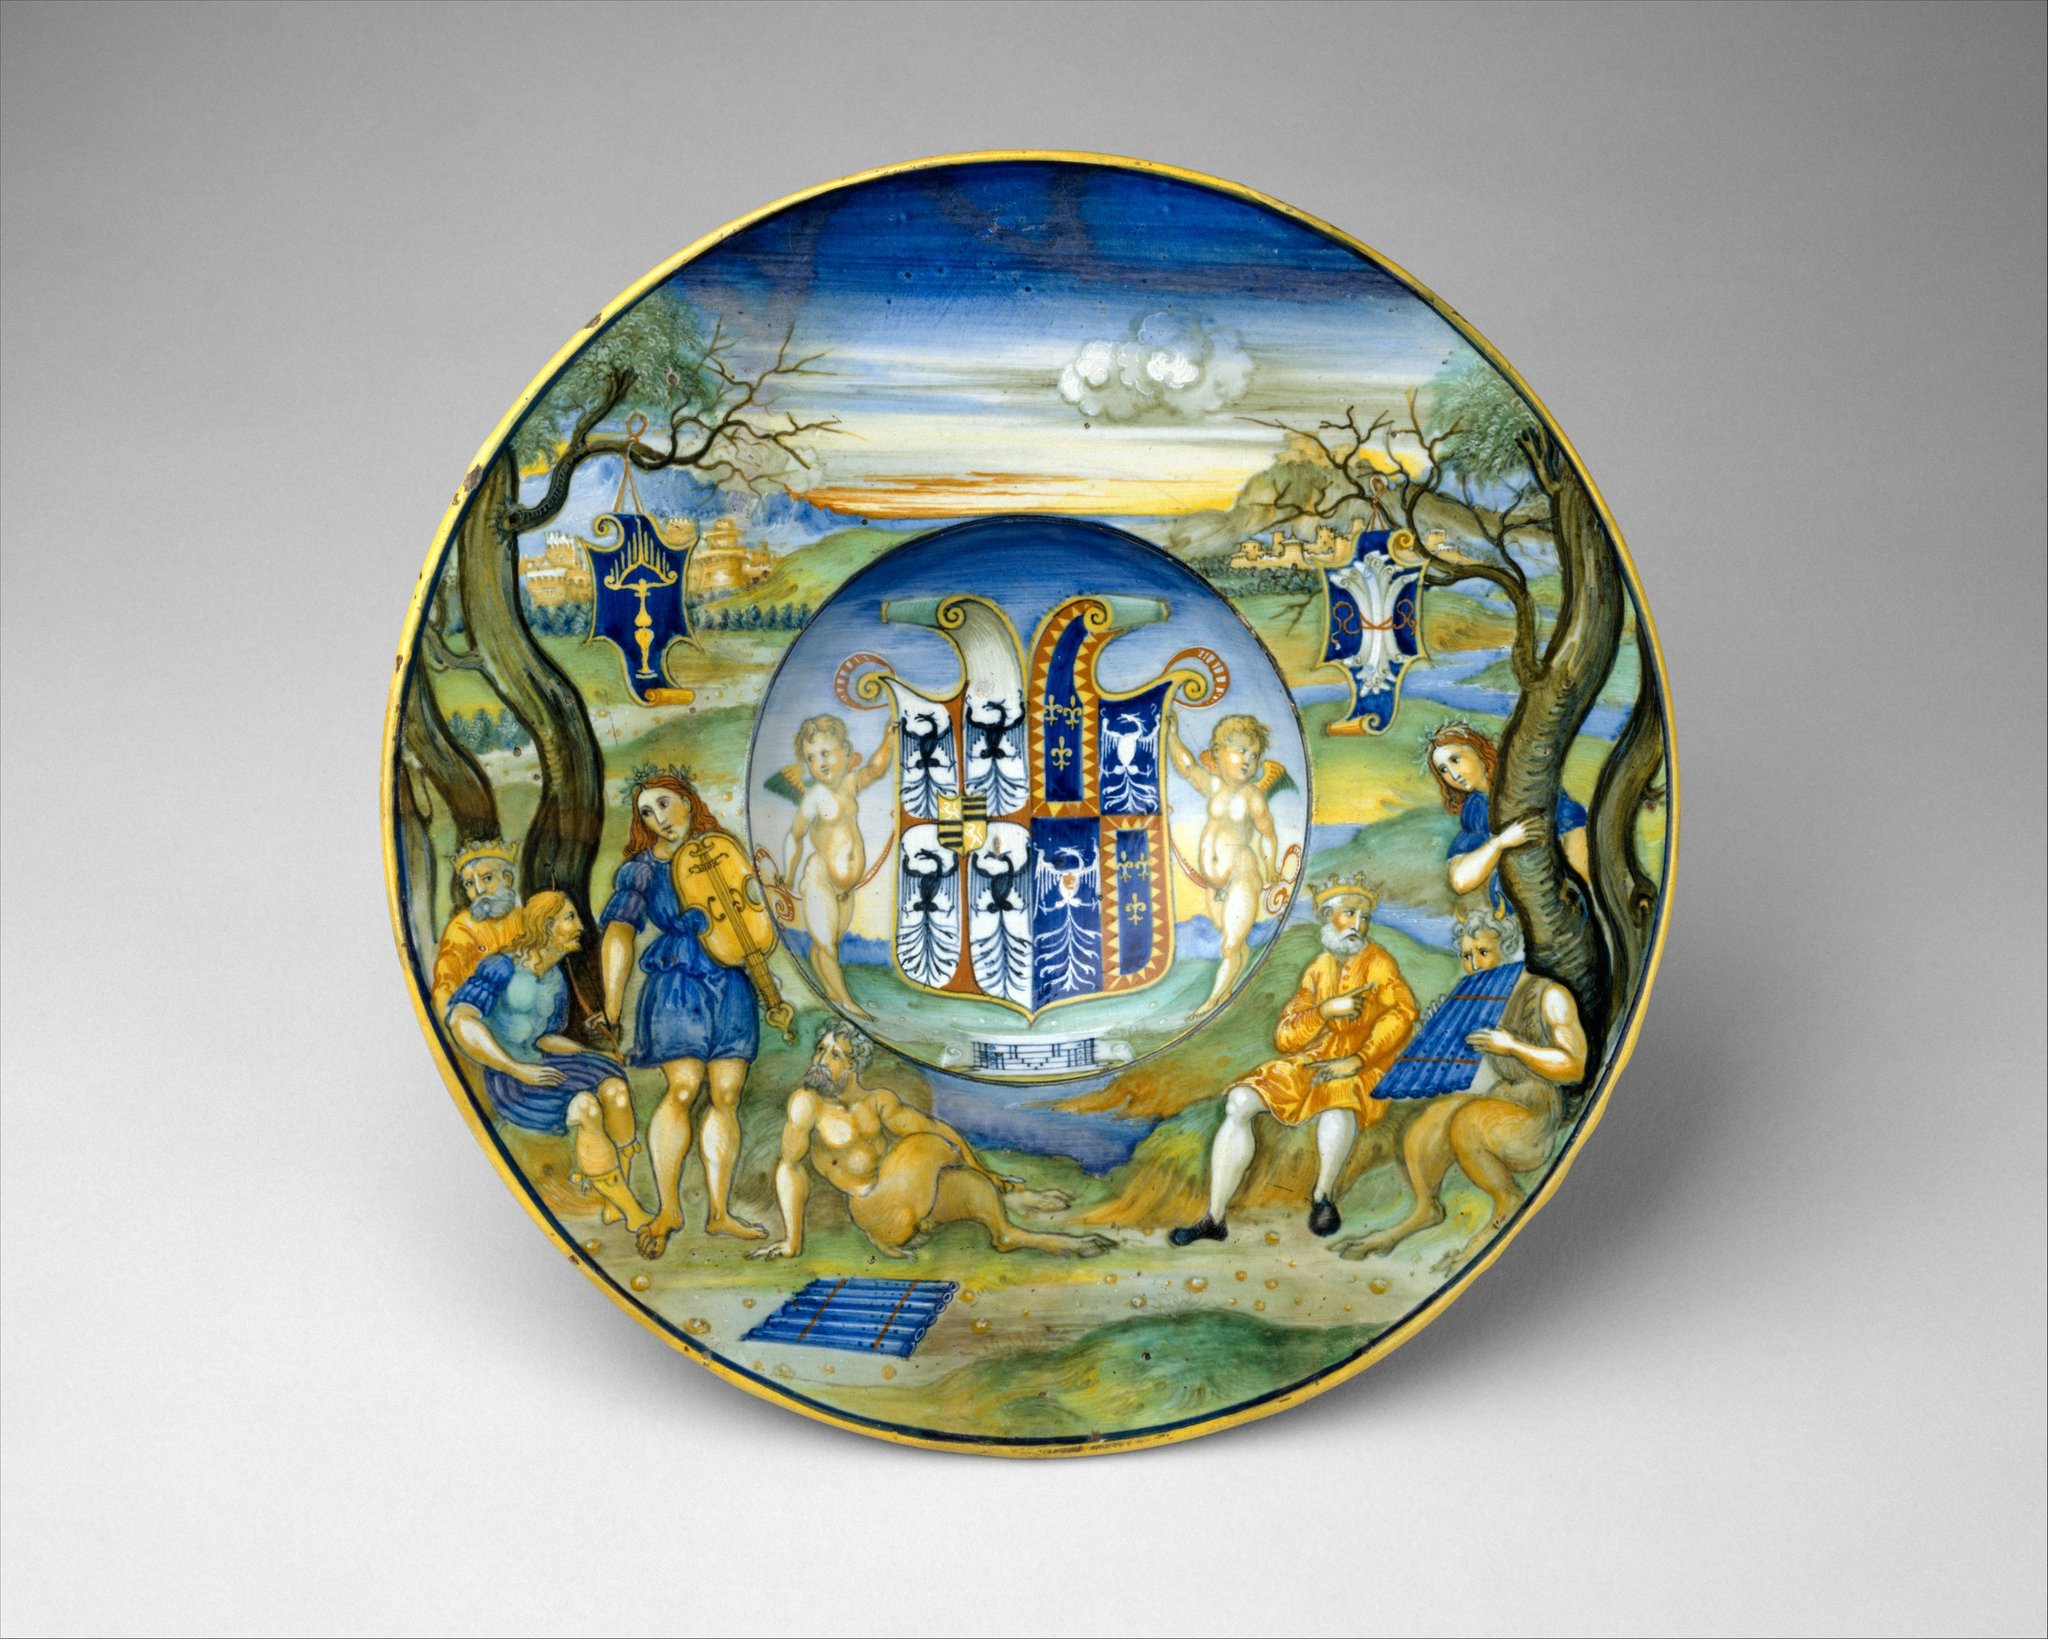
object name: plate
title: Armorial Plate (tondino): The story of King Midas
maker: nicola da urbino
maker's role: artist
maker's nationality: italian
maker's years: 1520-1538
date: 1520-1525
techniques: maiolica, glazing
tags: musical instruments,men,apollo,satyrs,coat of arms,musicians